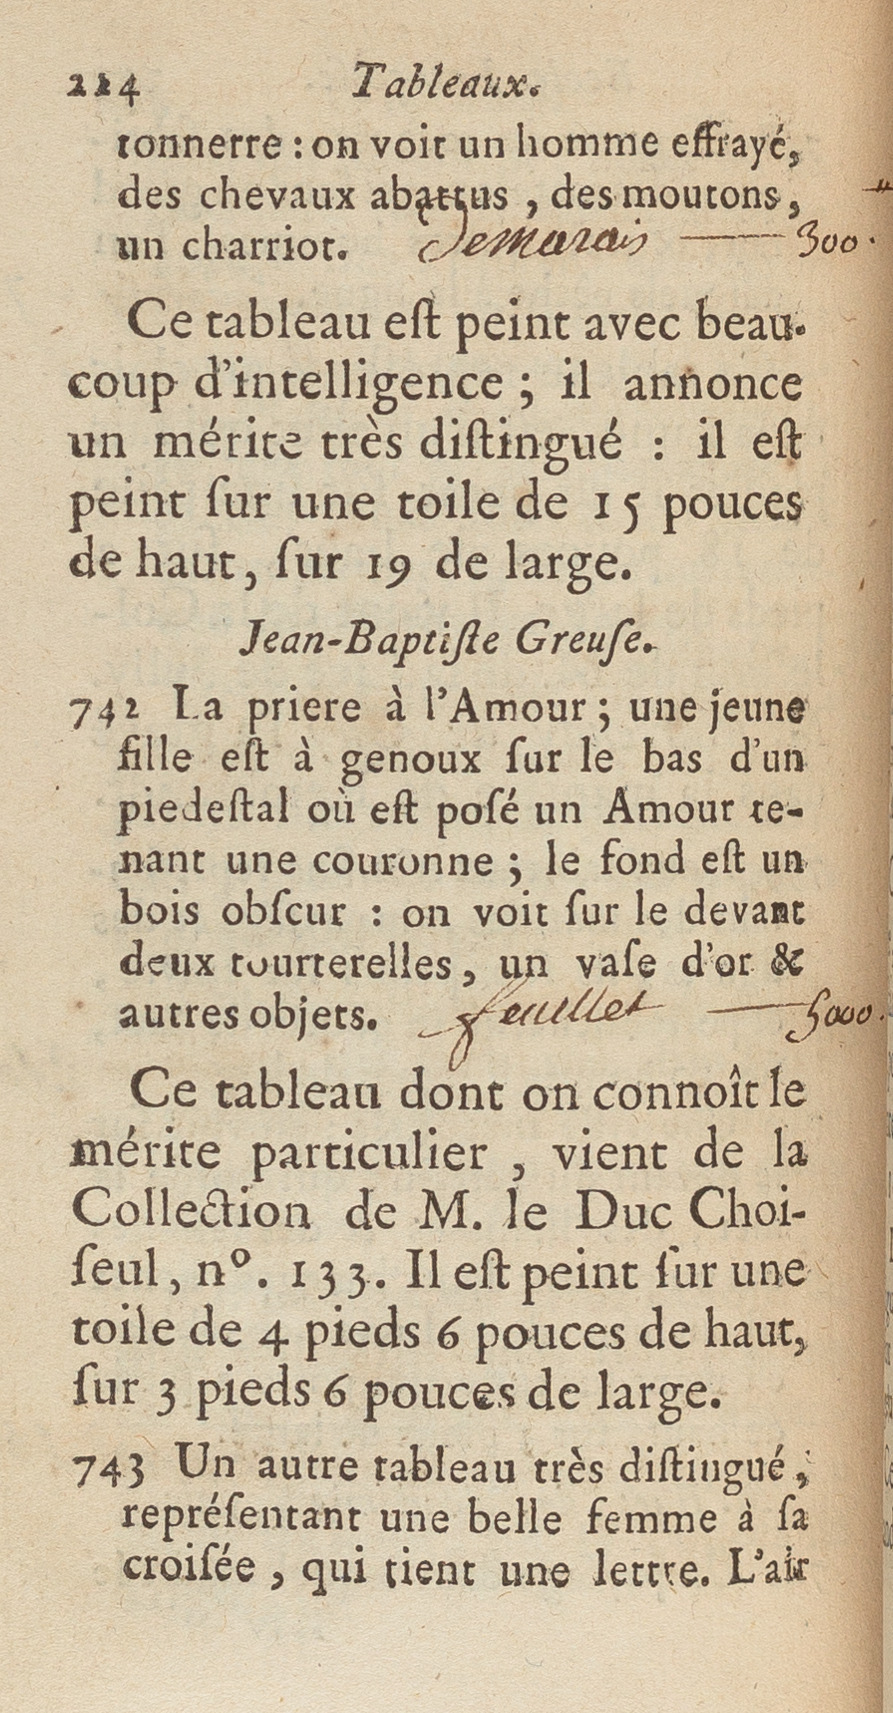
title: Catalogue d'une riche collection de tableaux des maîtres les plus célebres des trois écoles : qui composent le cabinet de feu son Altesse Sérenissime Monseigneur le Prince de Conti, prince du sang, & grand prieur de France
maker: pierre rémy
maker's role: publisher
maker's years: 1787-1791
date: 1777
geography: france